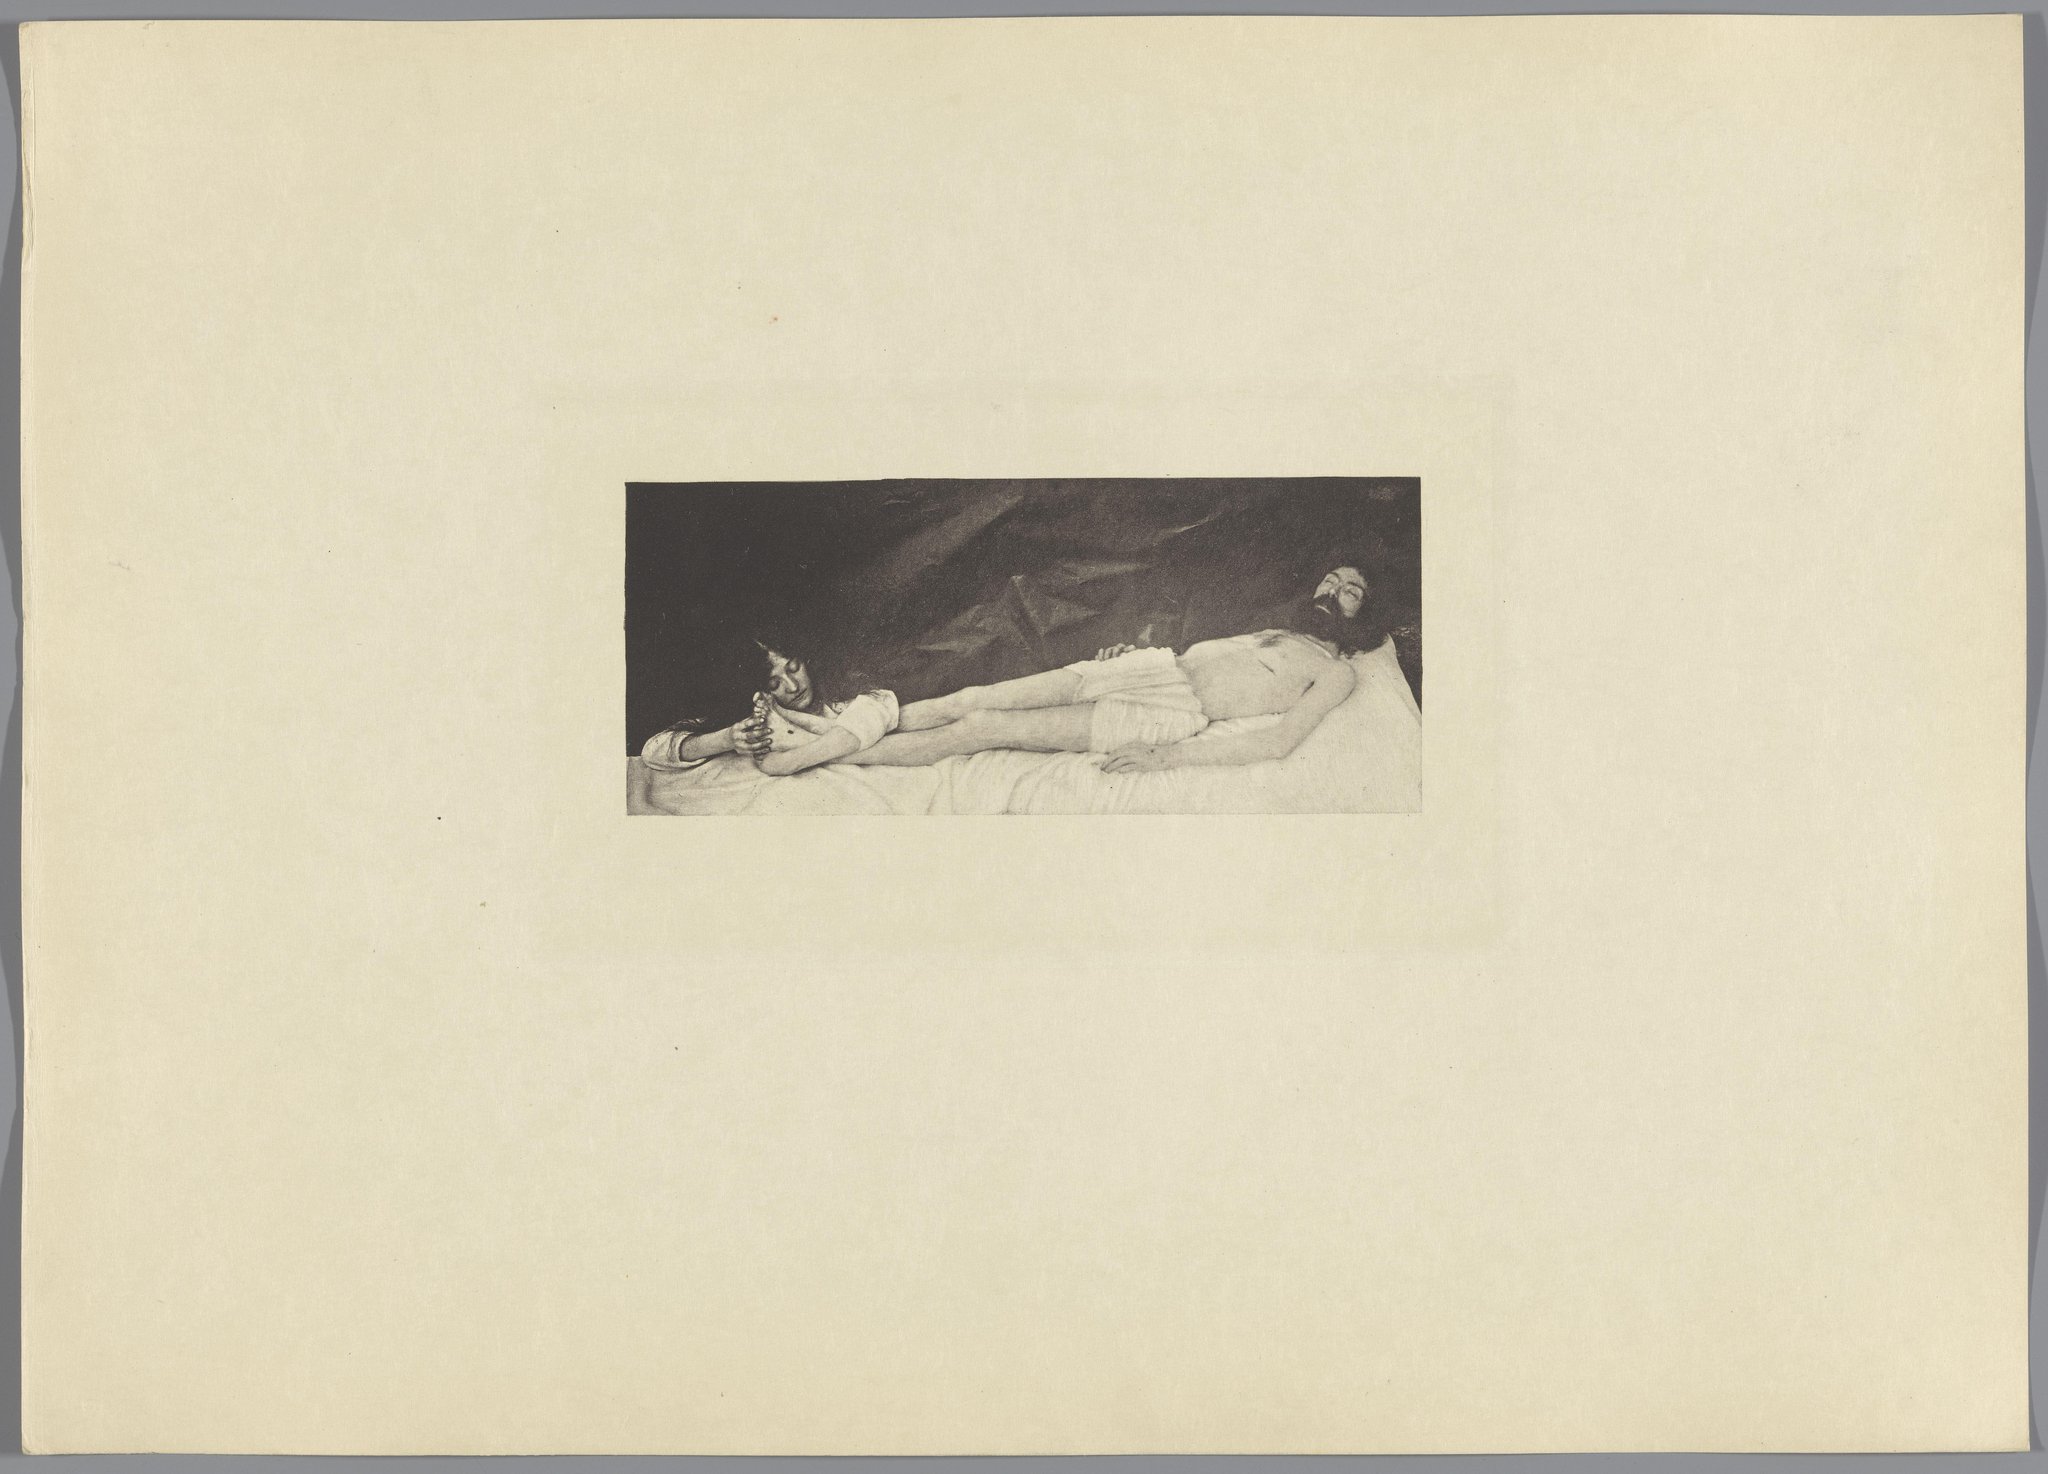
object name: photomechanical print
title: Christ au tombeau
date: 1891-1896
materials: paper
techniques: photoaquatint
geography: paris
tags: christ is laid down ~ descent from the cross, lying figure